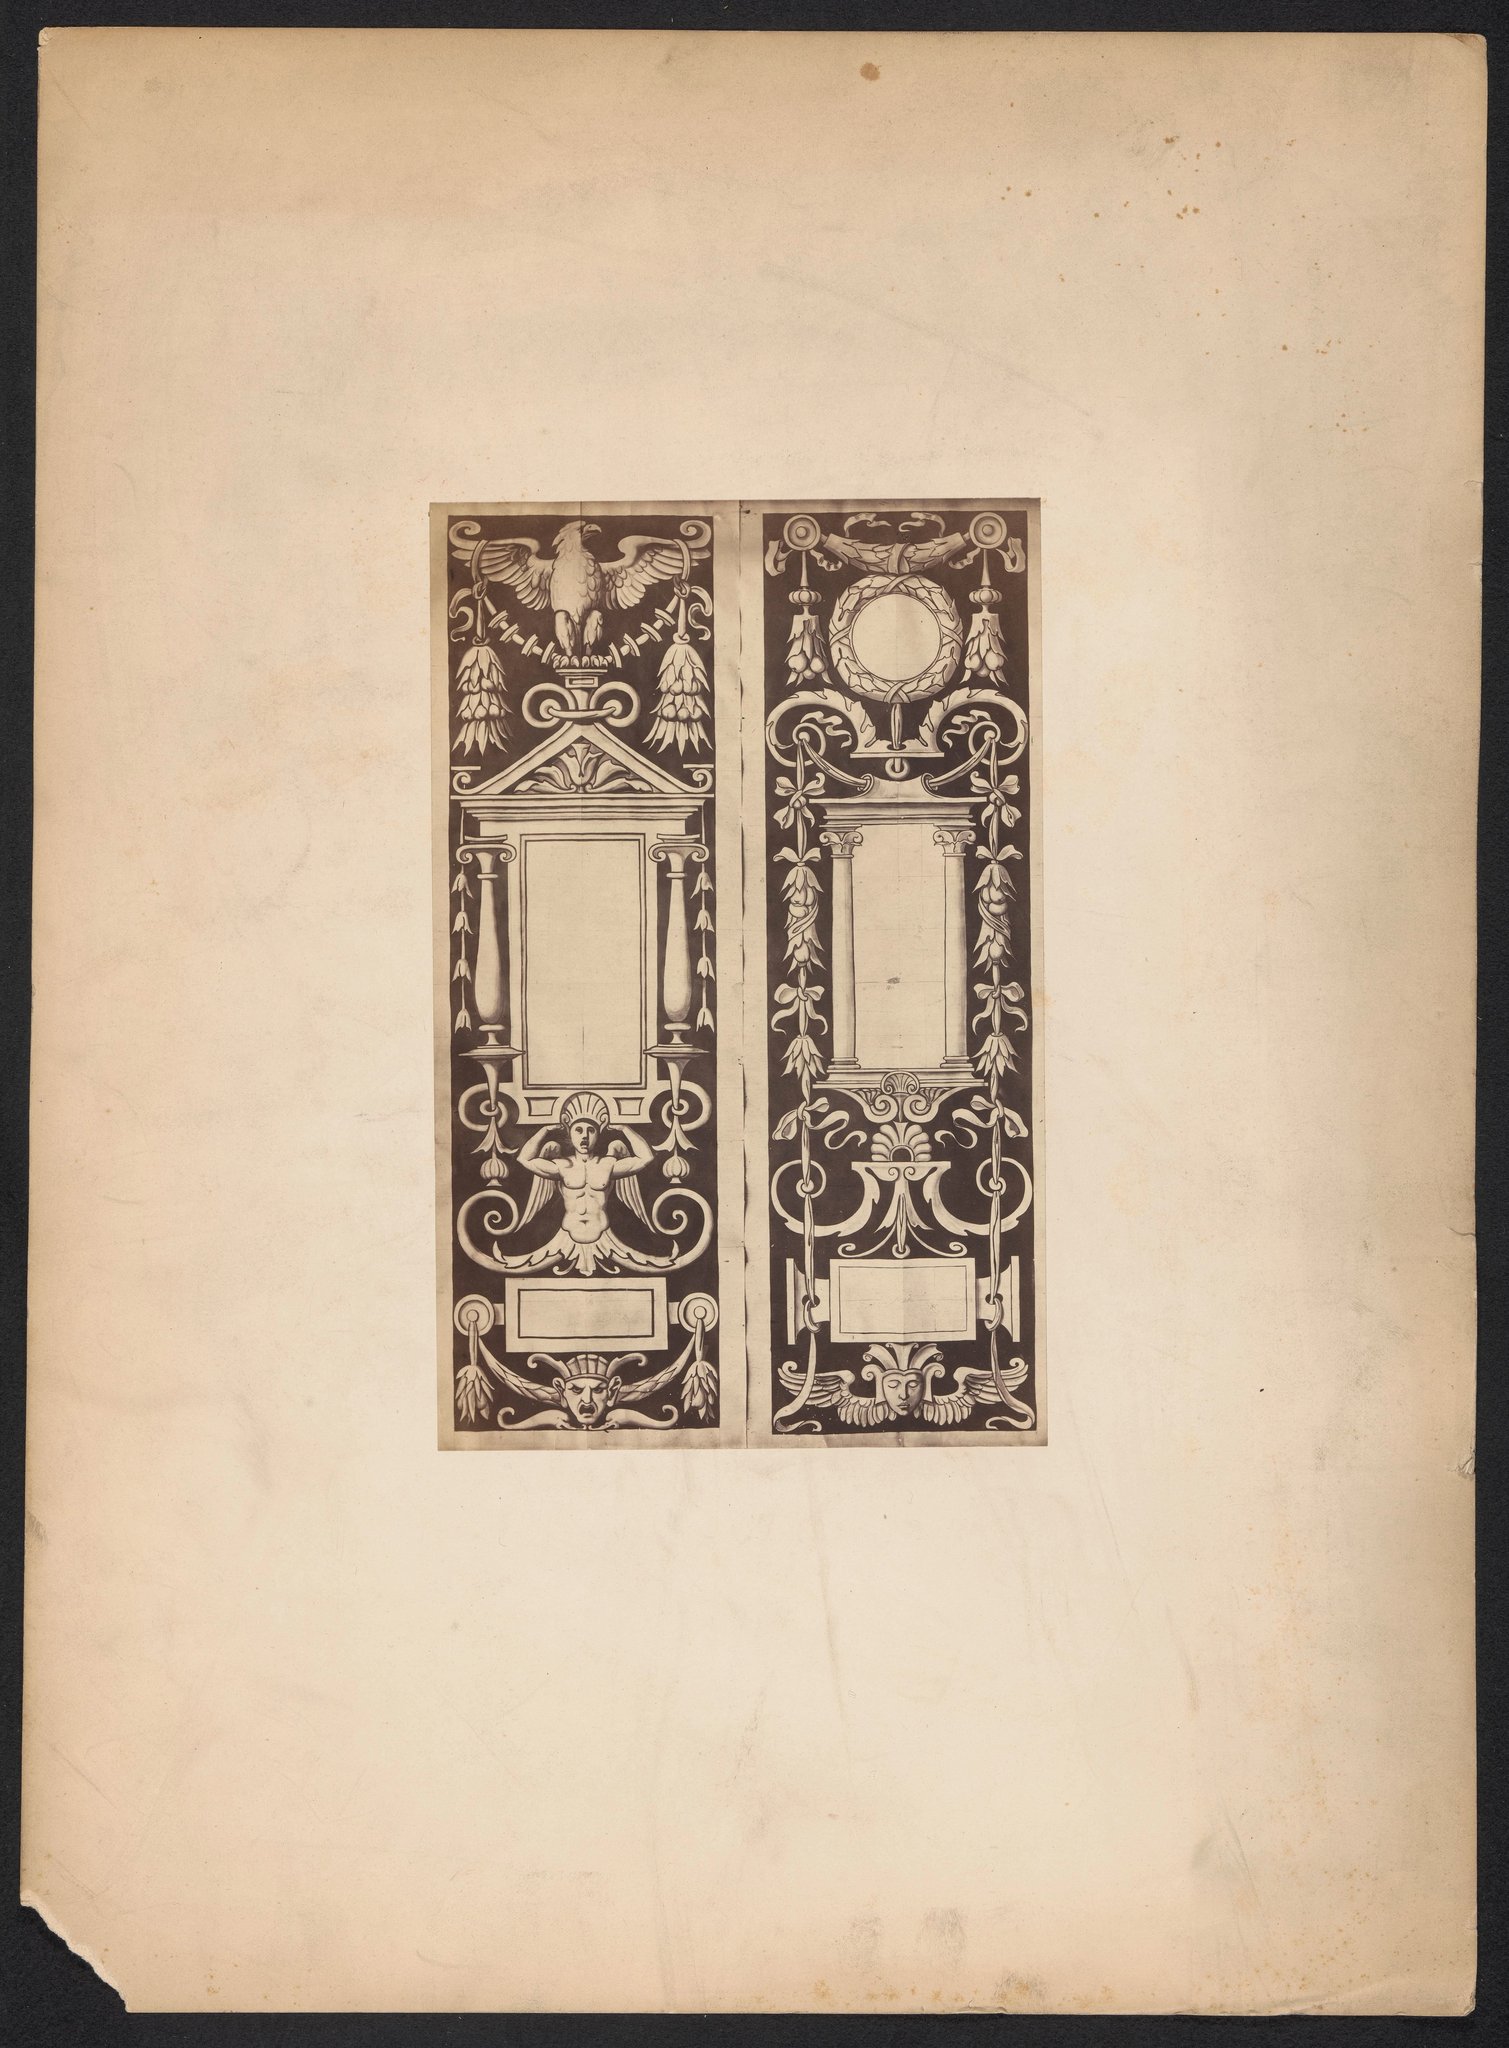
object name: photograph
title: Twee ornamentprenten met een vogel en een krans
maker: Anonymous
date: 1875-1900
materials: cardboard, photographic support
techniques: albumen print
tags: monumental door, porch, 'aediculum', ornamental birds, ornament ~ human parts, garland, wreath, other fantasy ornament, mask, mascaron ~ ornament, ornament derived from architectural details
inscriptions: collector's mark: Lugt 3937